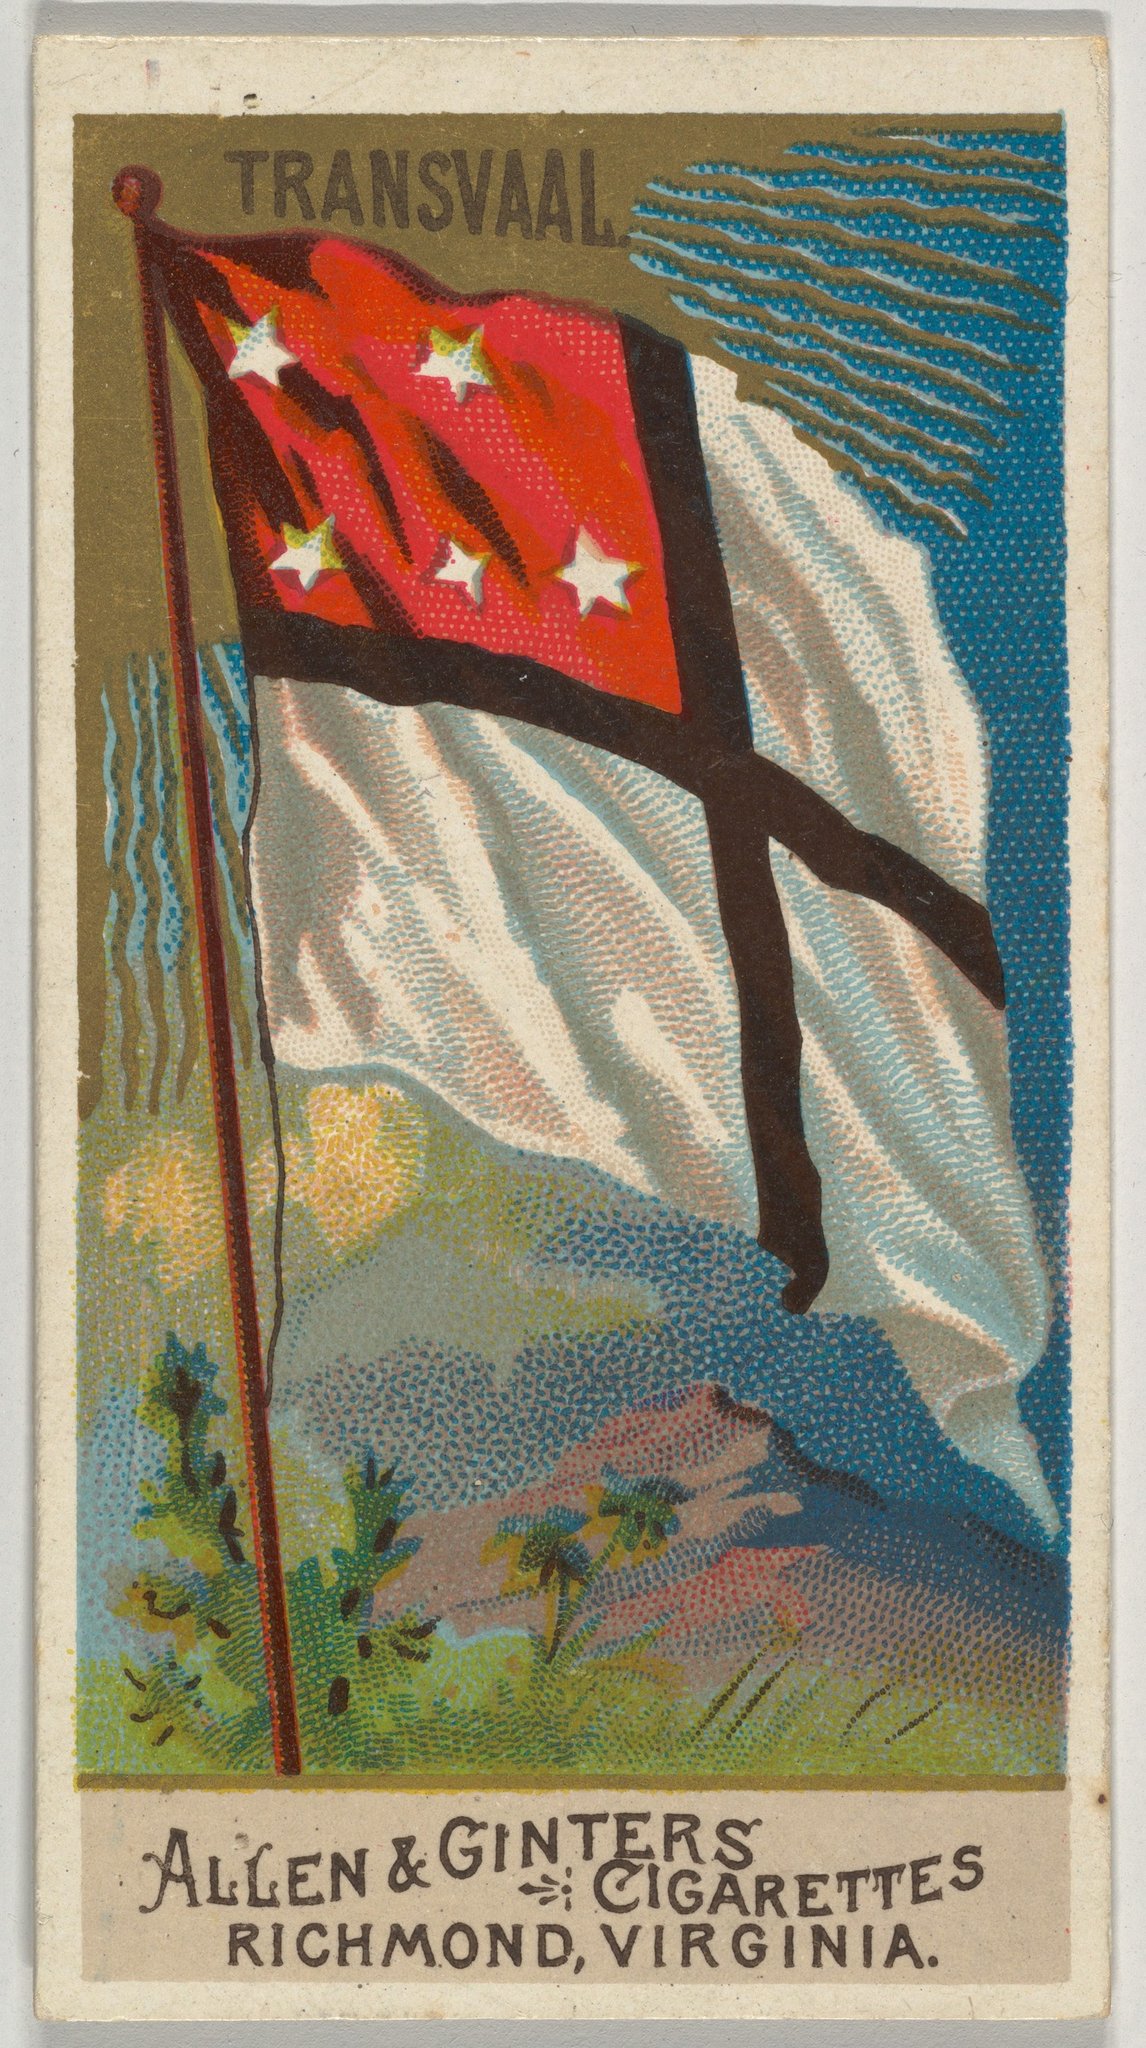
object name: print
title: Transvaal, from Flags of All Nations, Series 2 (N10) for Allen & Ginter Cigarettes Brands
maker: allen & ginter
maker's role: publisher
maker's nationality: american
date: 1890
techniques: color lithograph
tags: flags